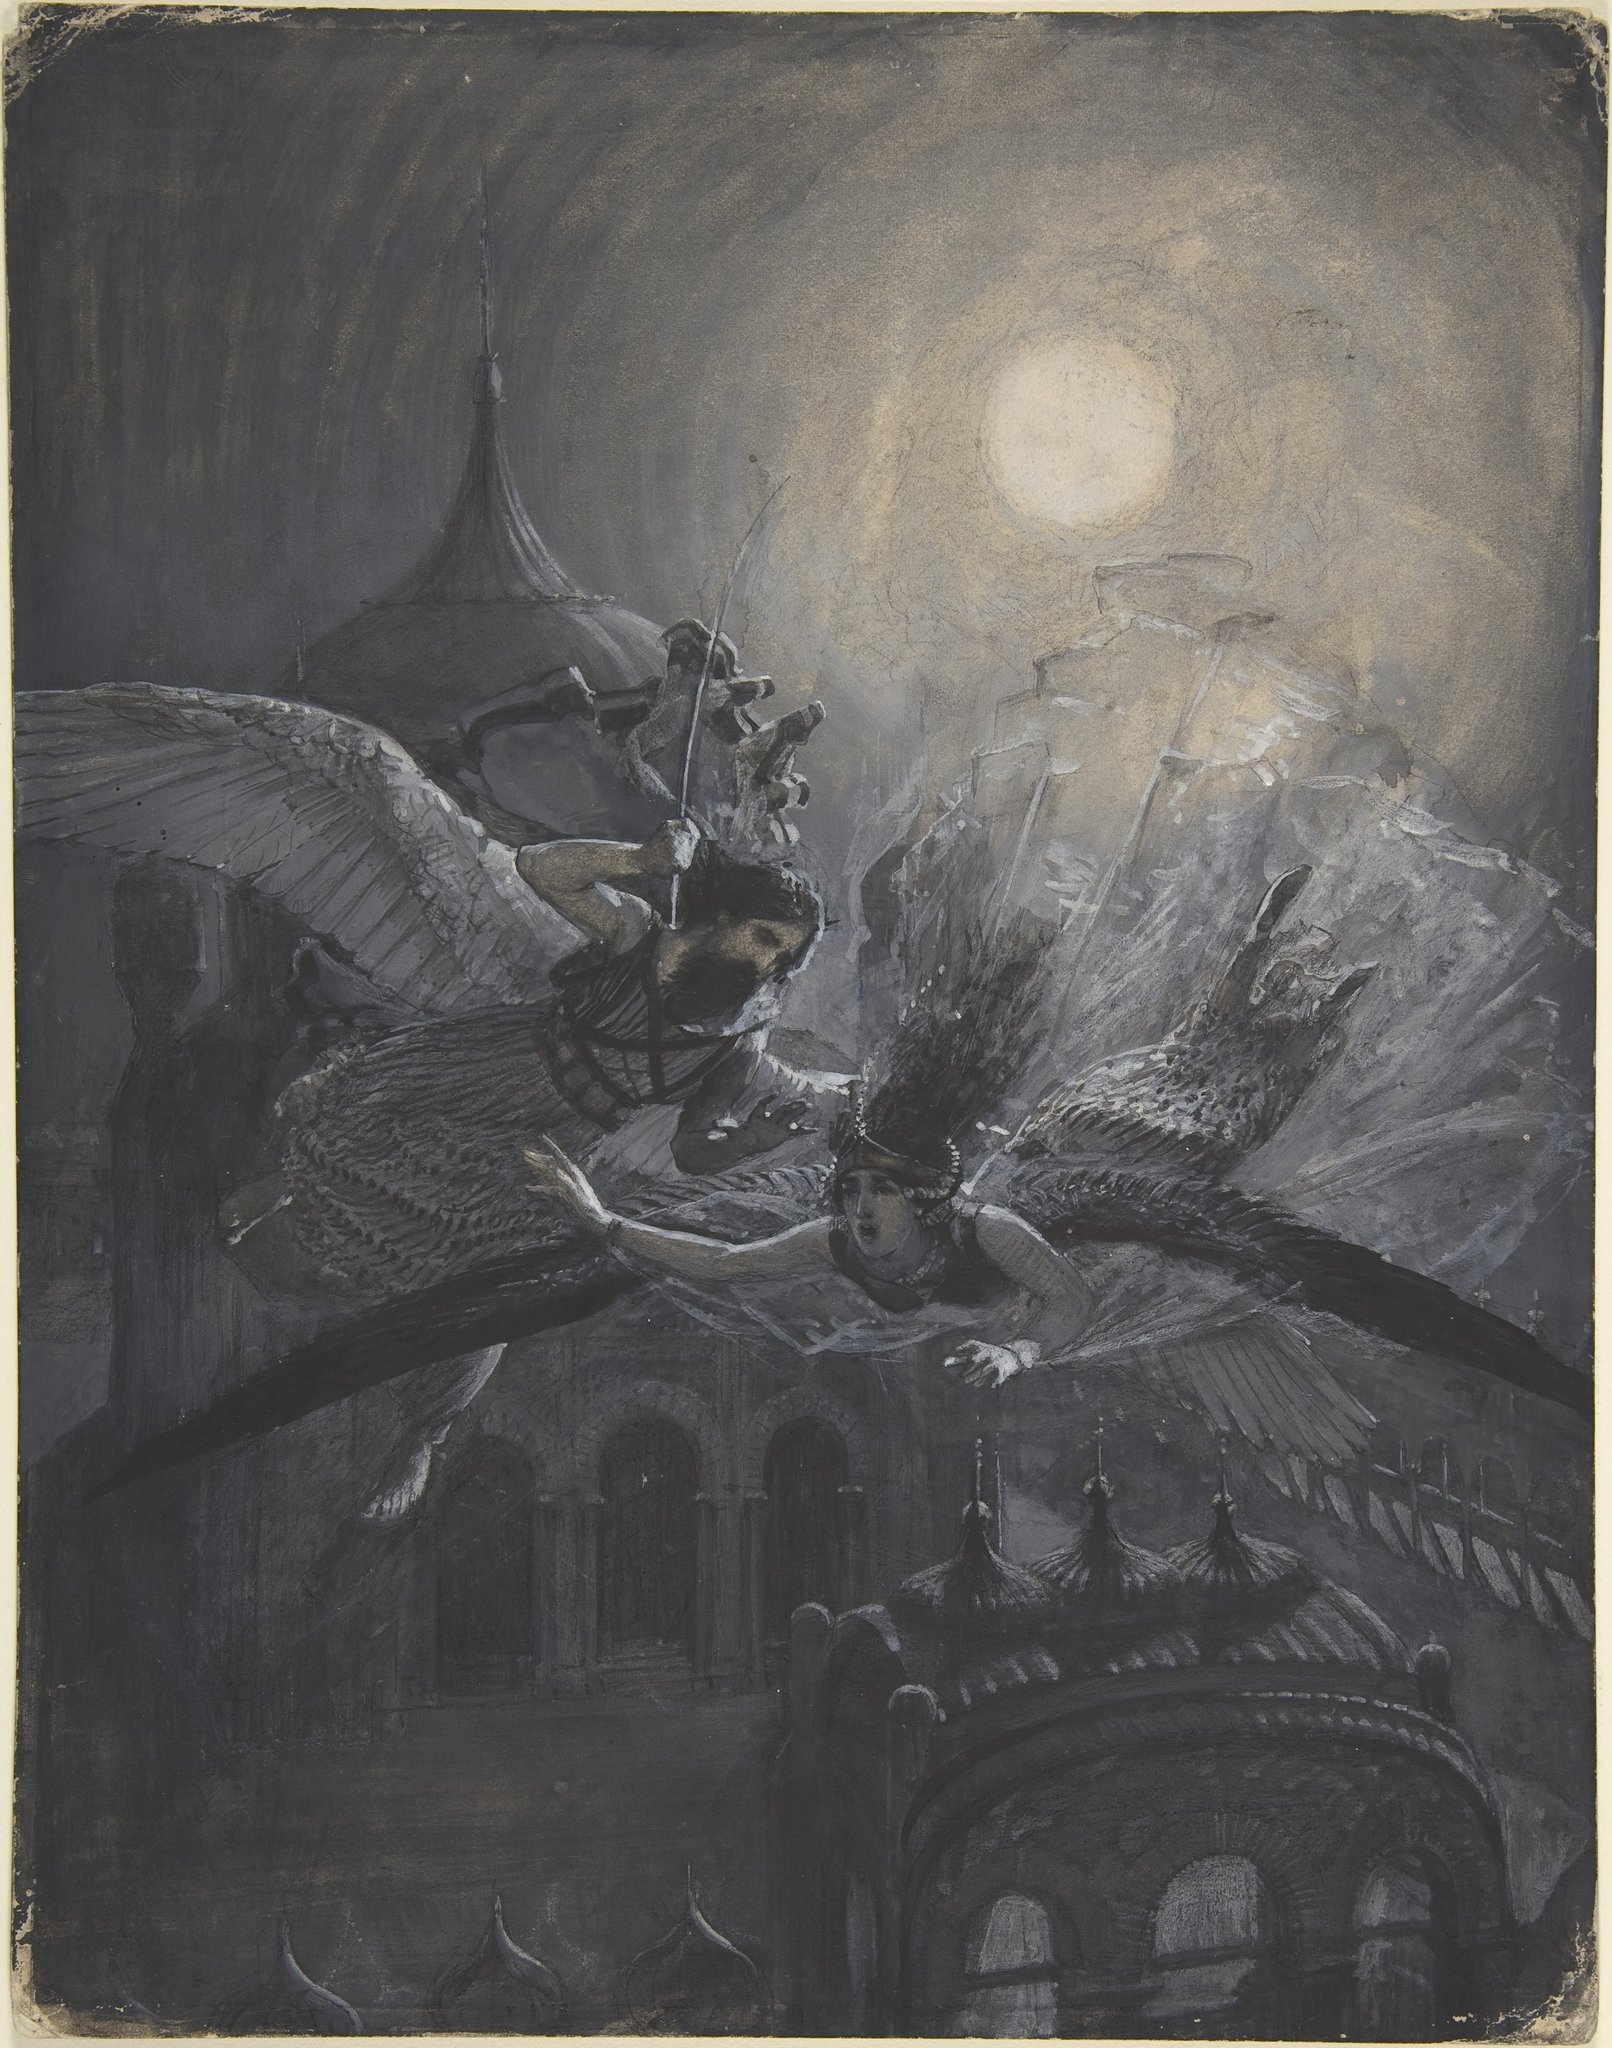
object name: drawing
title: Angel Scourging a Harpy (recto); Athletic Scene (verso)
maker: anonymous, british, 19th century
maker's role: artist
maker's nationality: british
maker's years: 1800-1900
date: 1890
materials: paint, gouache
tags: angels,punishment